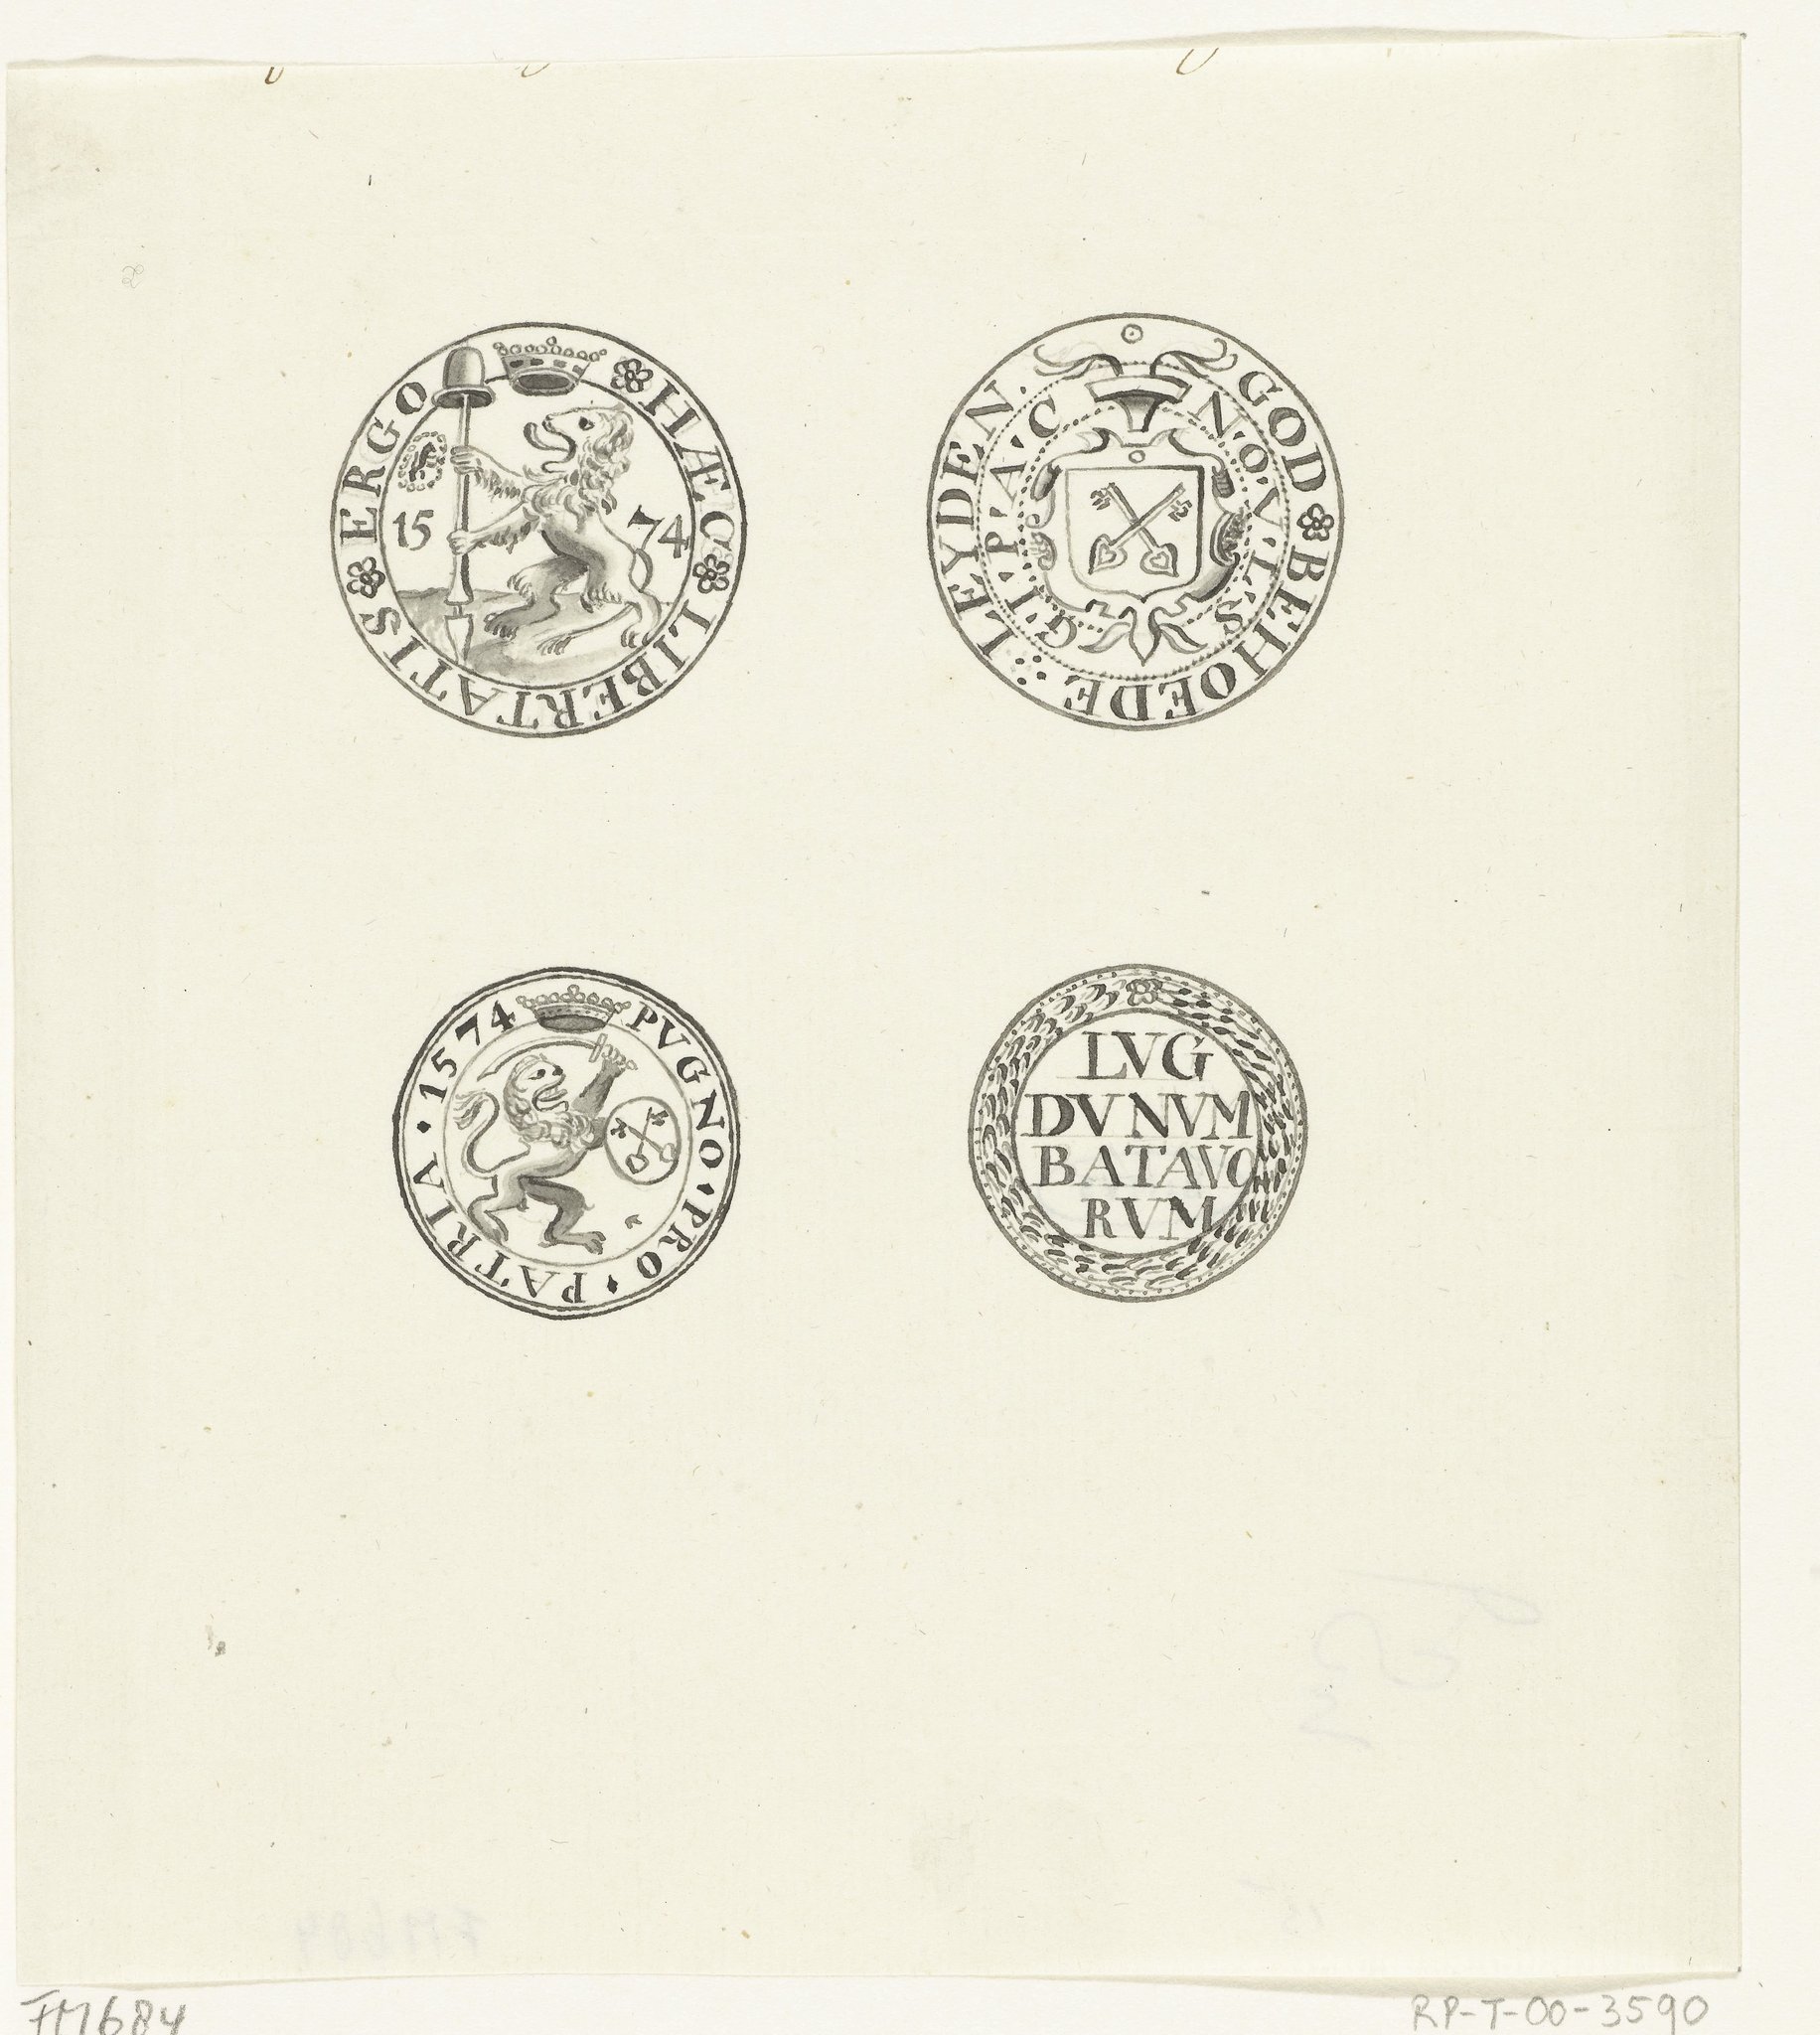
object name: historical object representation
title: Twee papieren noodmunten uit het beleg van Leiden, 1574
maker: Anonymous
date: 1700-1899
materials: ink, paper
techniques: brush, pen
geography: netherlands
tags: coin, leiden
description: Twee papieren noodmunten uit het beleg van Leiden, 1574. Voorzijde leeuw met lans en vrijheidshoed en leeuw met zwaard en wapen van Leiden, keerzijde wapen van Leiden en opschrift in Latijn.